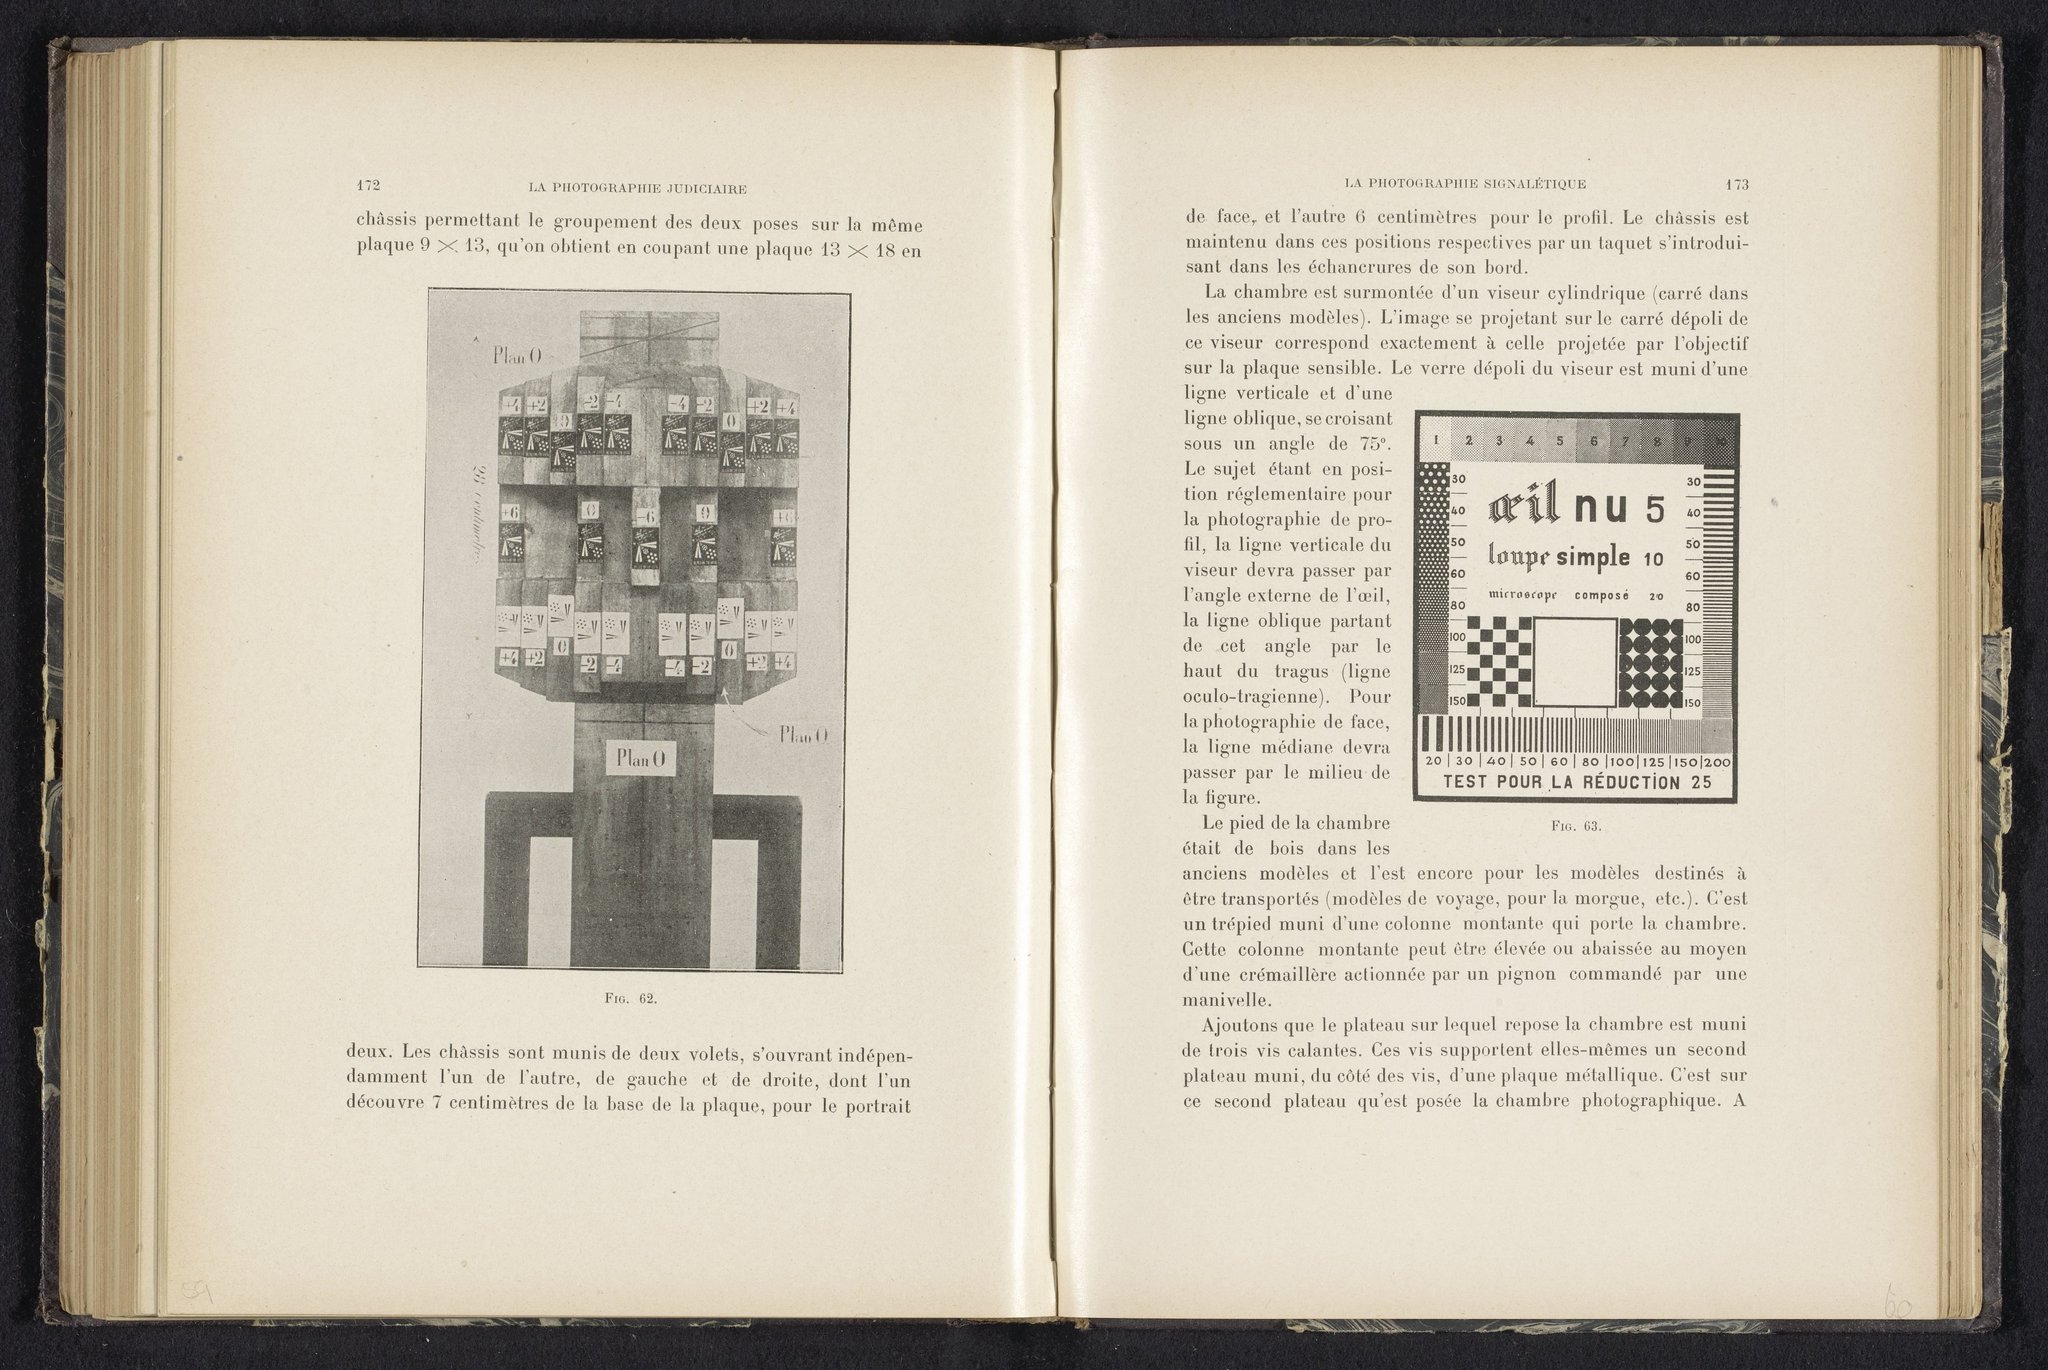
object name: page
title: Lensmeter voor het fotograferen van criminelen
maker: Anonymous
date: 1893-1903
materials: paper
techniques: autotype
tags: tools, aids, implements ~ crafts and industries, photography, criminals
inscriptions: number: ‘Fig. 62.’